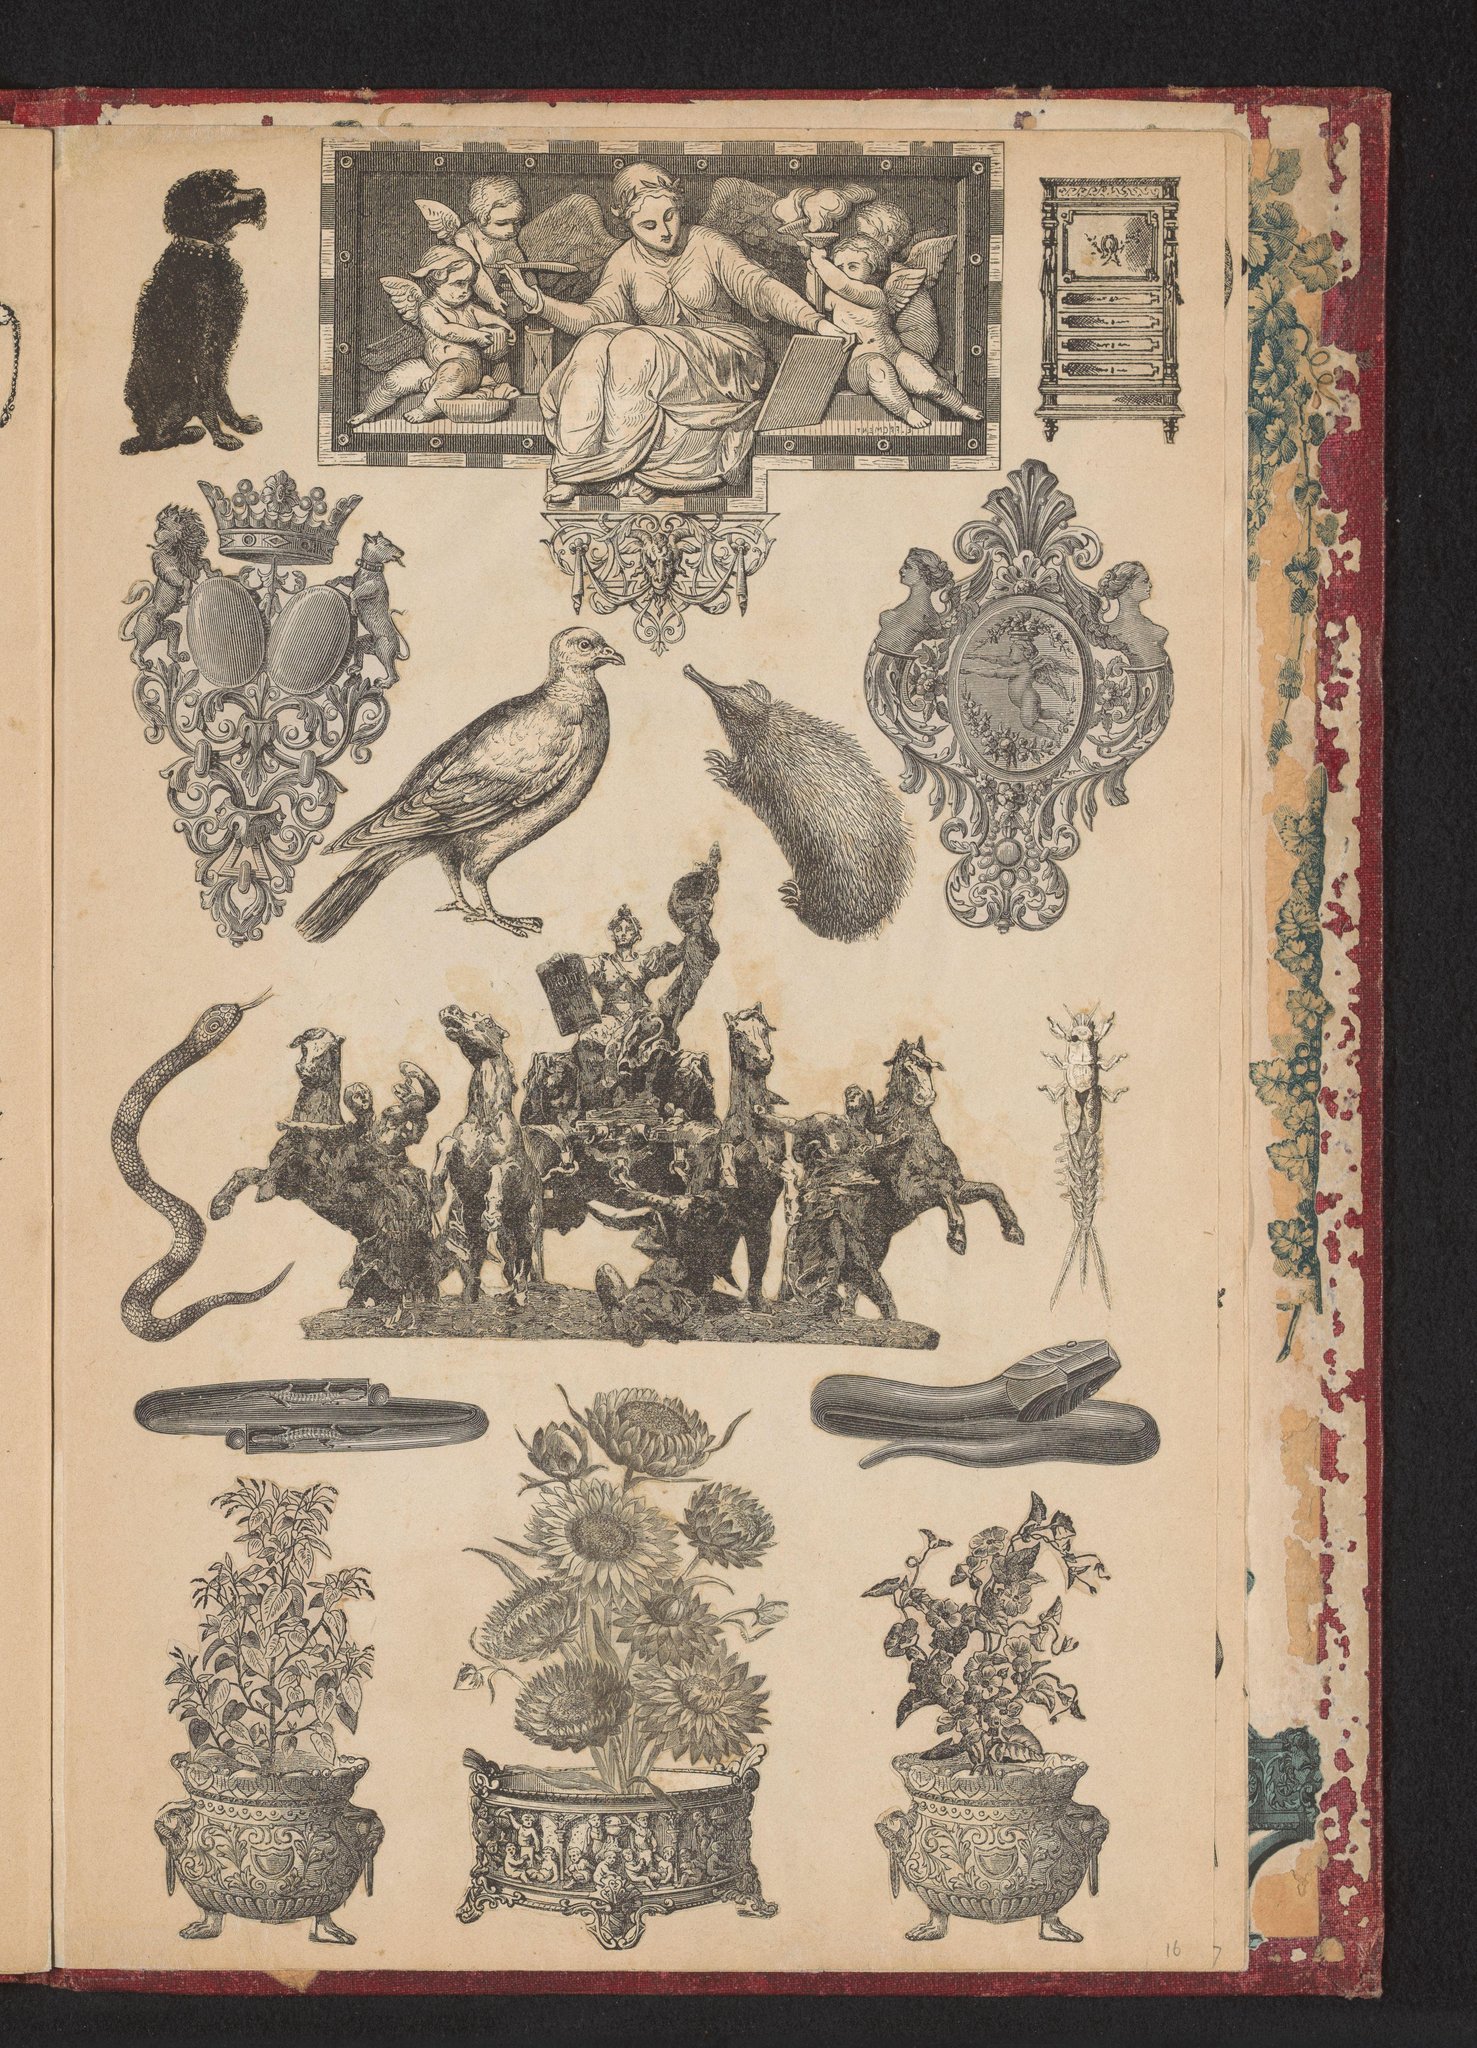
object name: collage visual work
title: Collage van uitgeknipte prenten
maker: Anonymous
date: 1870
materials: paper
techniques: engraving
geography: paris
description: Collage van uitgeknipte prenten. Onderdeel van een album met 18 bladen, aan beide zijden beplakt met uitgeknipte prenten, vermoedelijk afkomstig uit 19e-eeuwse tijdschiften.